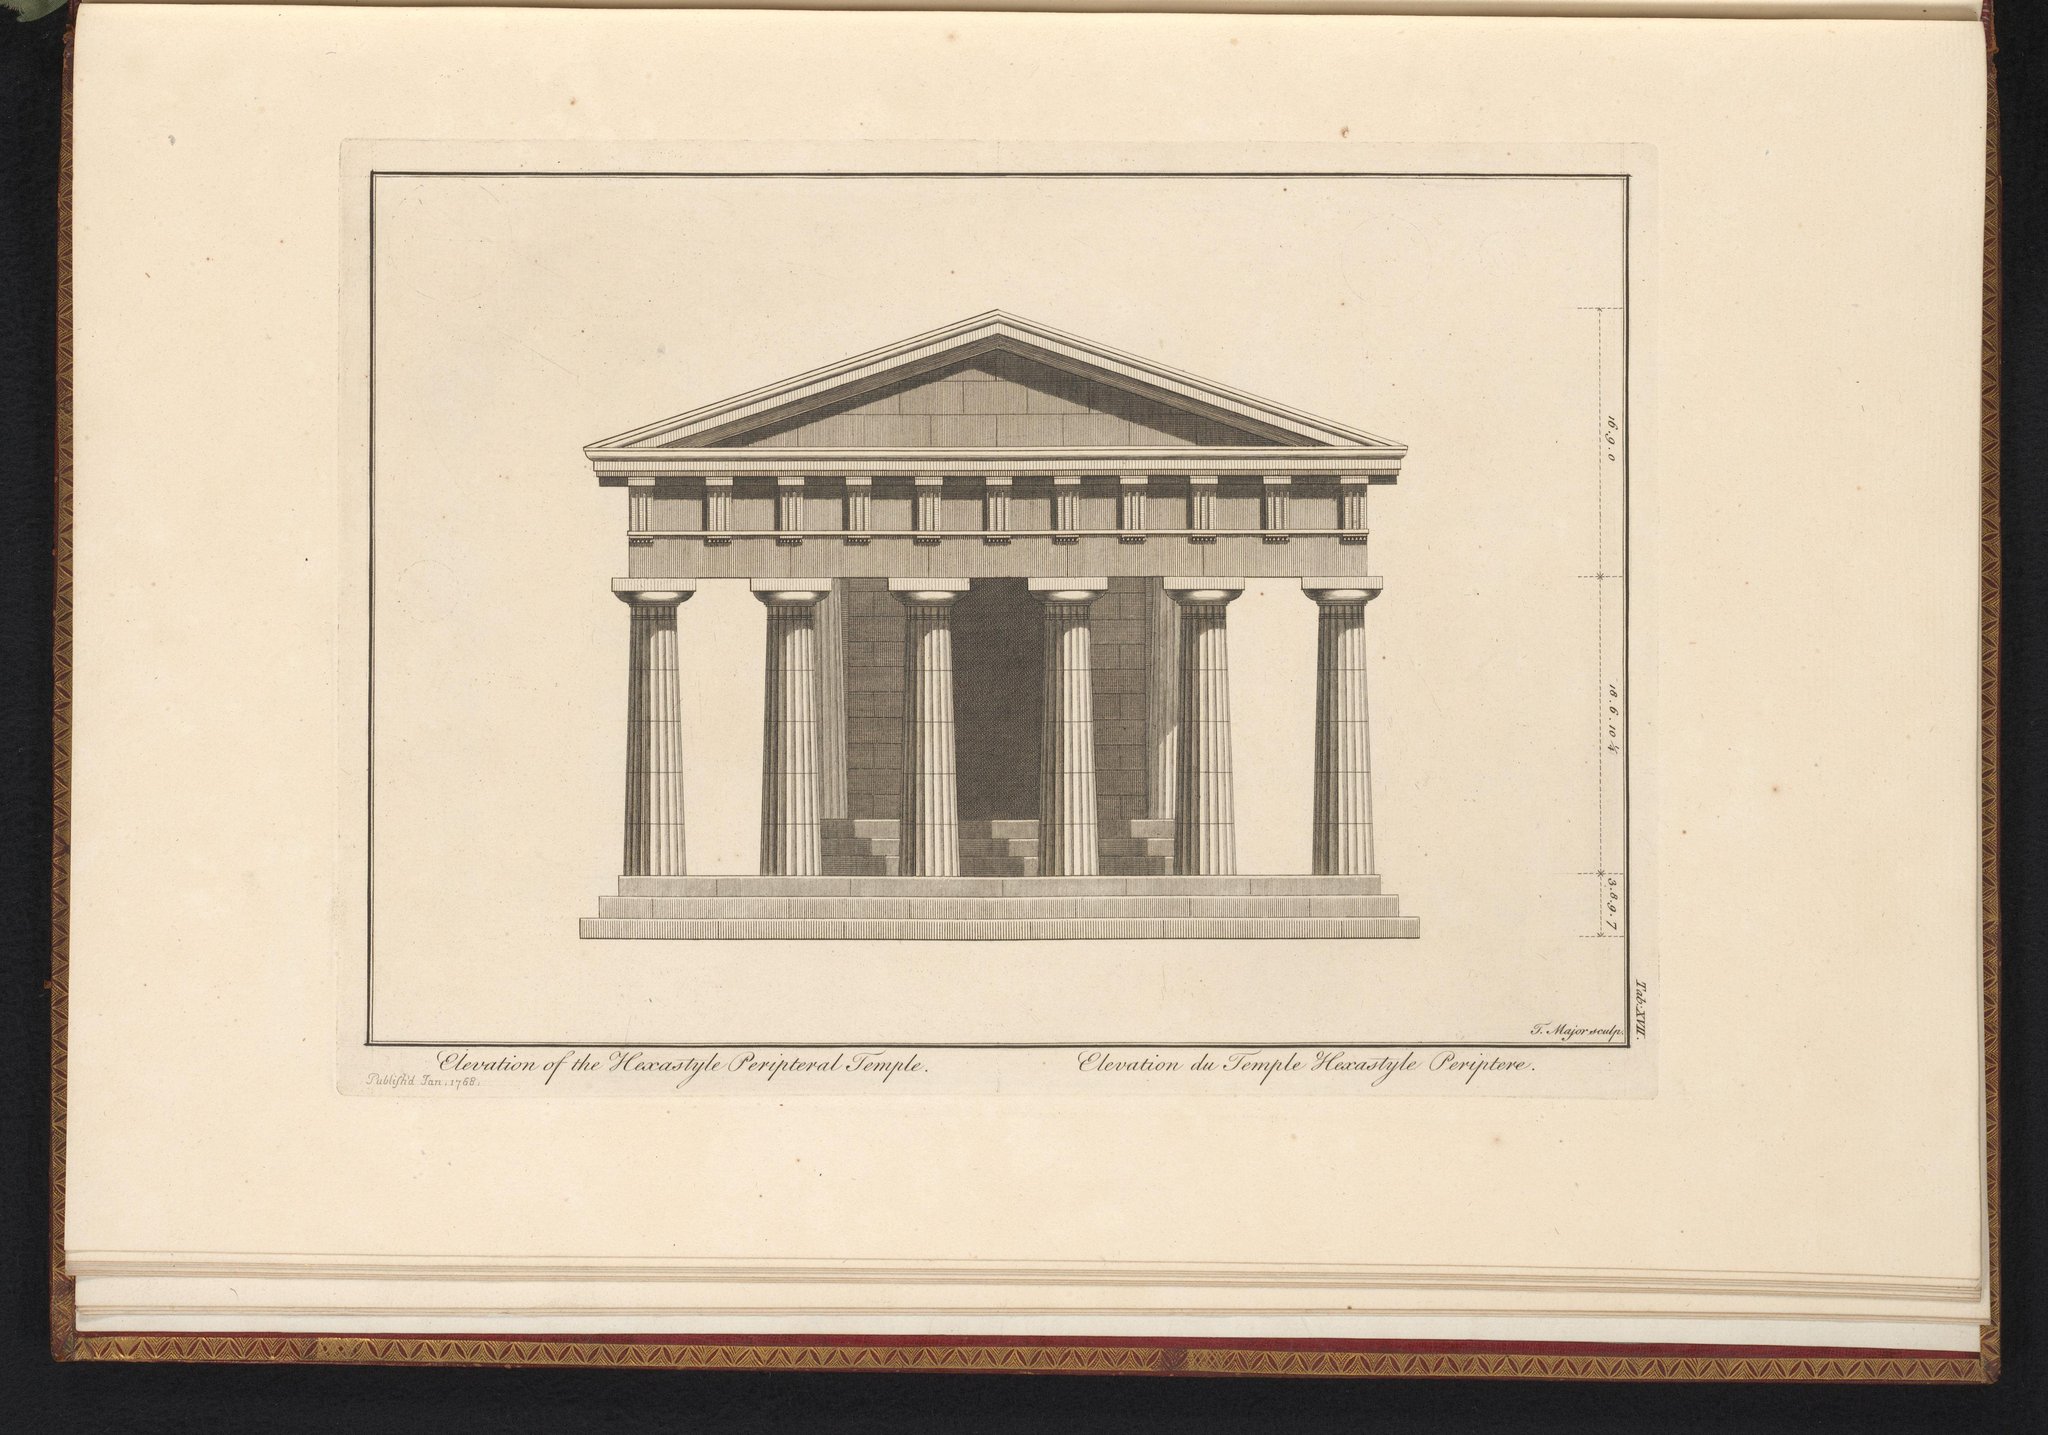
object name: page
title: Elevation of the Hexastyle Peripteral Temple / Elevation du Temple Hexastyle Periptere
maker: thomas major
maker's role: print maker, publisher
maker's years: 1714-1799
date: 1768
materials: paper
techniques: engraving, etching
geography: london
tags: parts of church exterior and annexes: façade, architecture, temple, shrine ~ greek religion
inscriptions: date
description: Genummerd: XVII. Schaalverdeling in de ondermarge. Prent maakt deel uit van een boek.